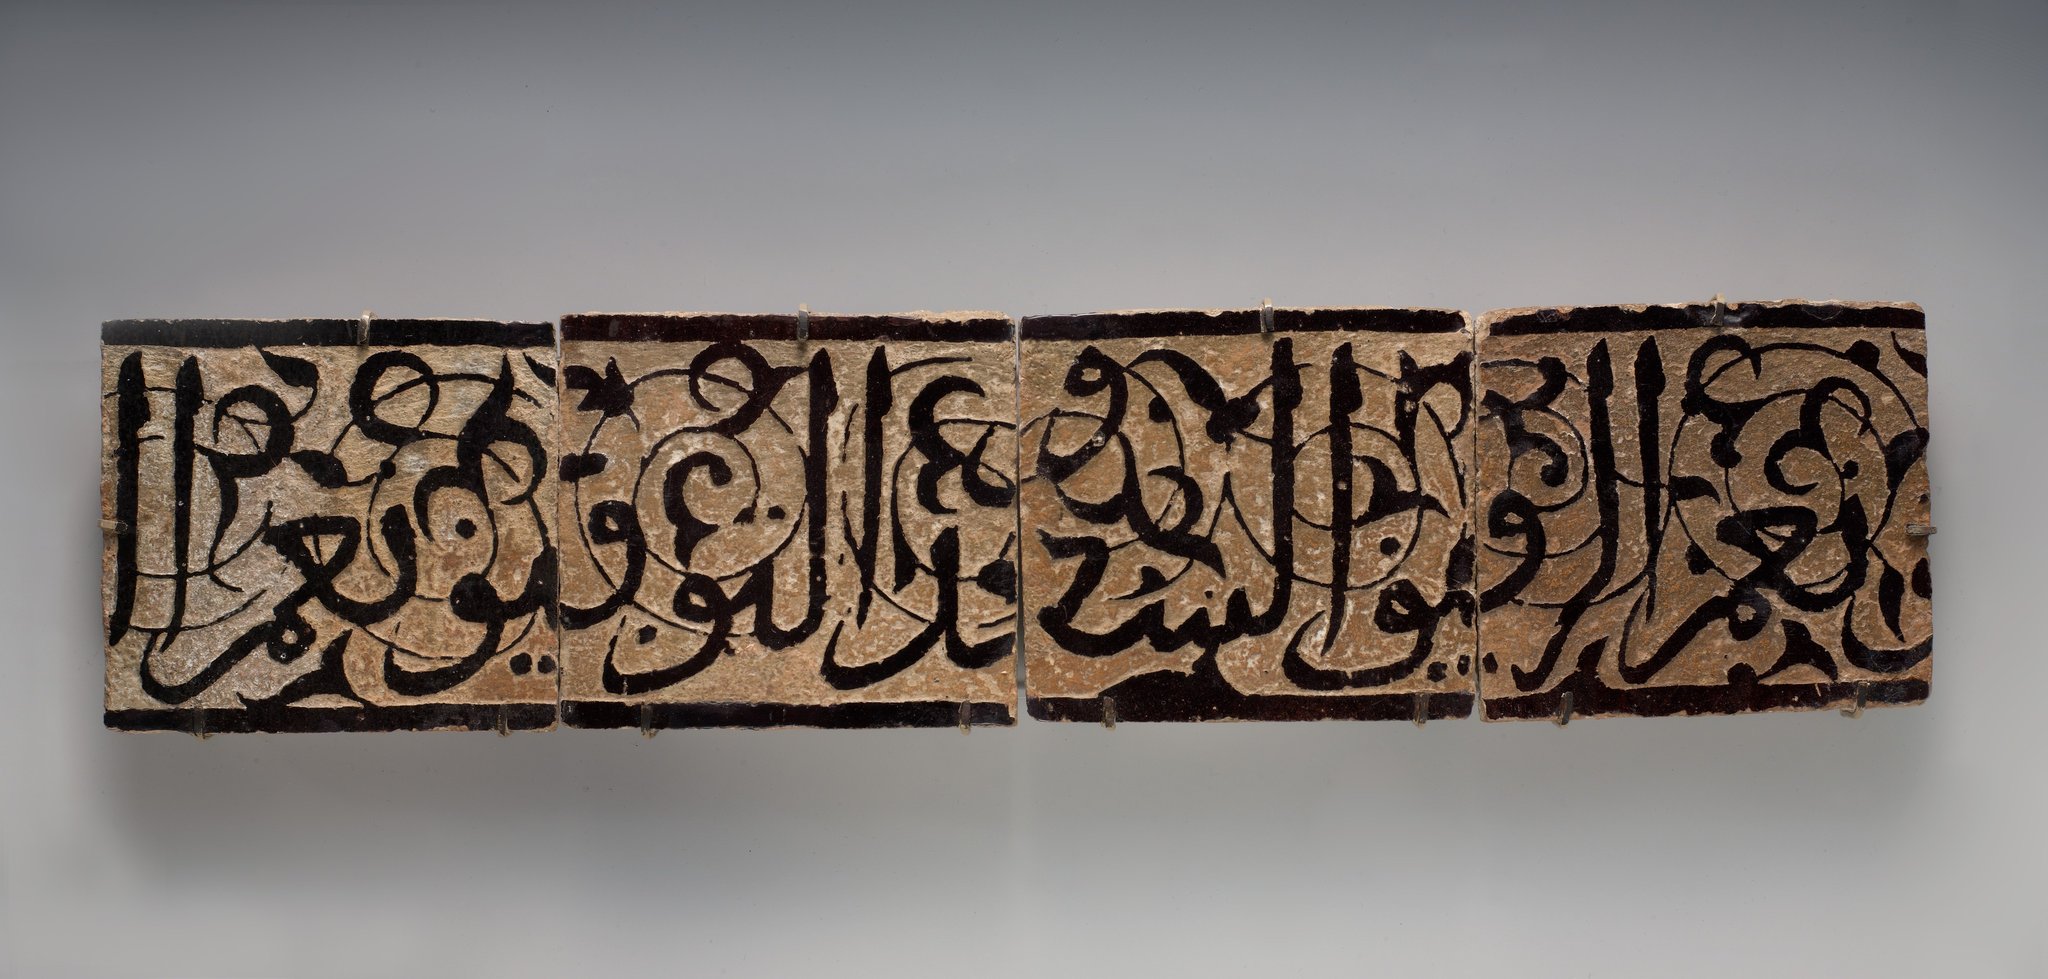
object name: tile panel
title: Panel of Four Calligraphic Tiles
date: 1301-1433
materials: stonepaste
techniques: carving, glazing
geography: morocco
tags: arabic,calligraphy